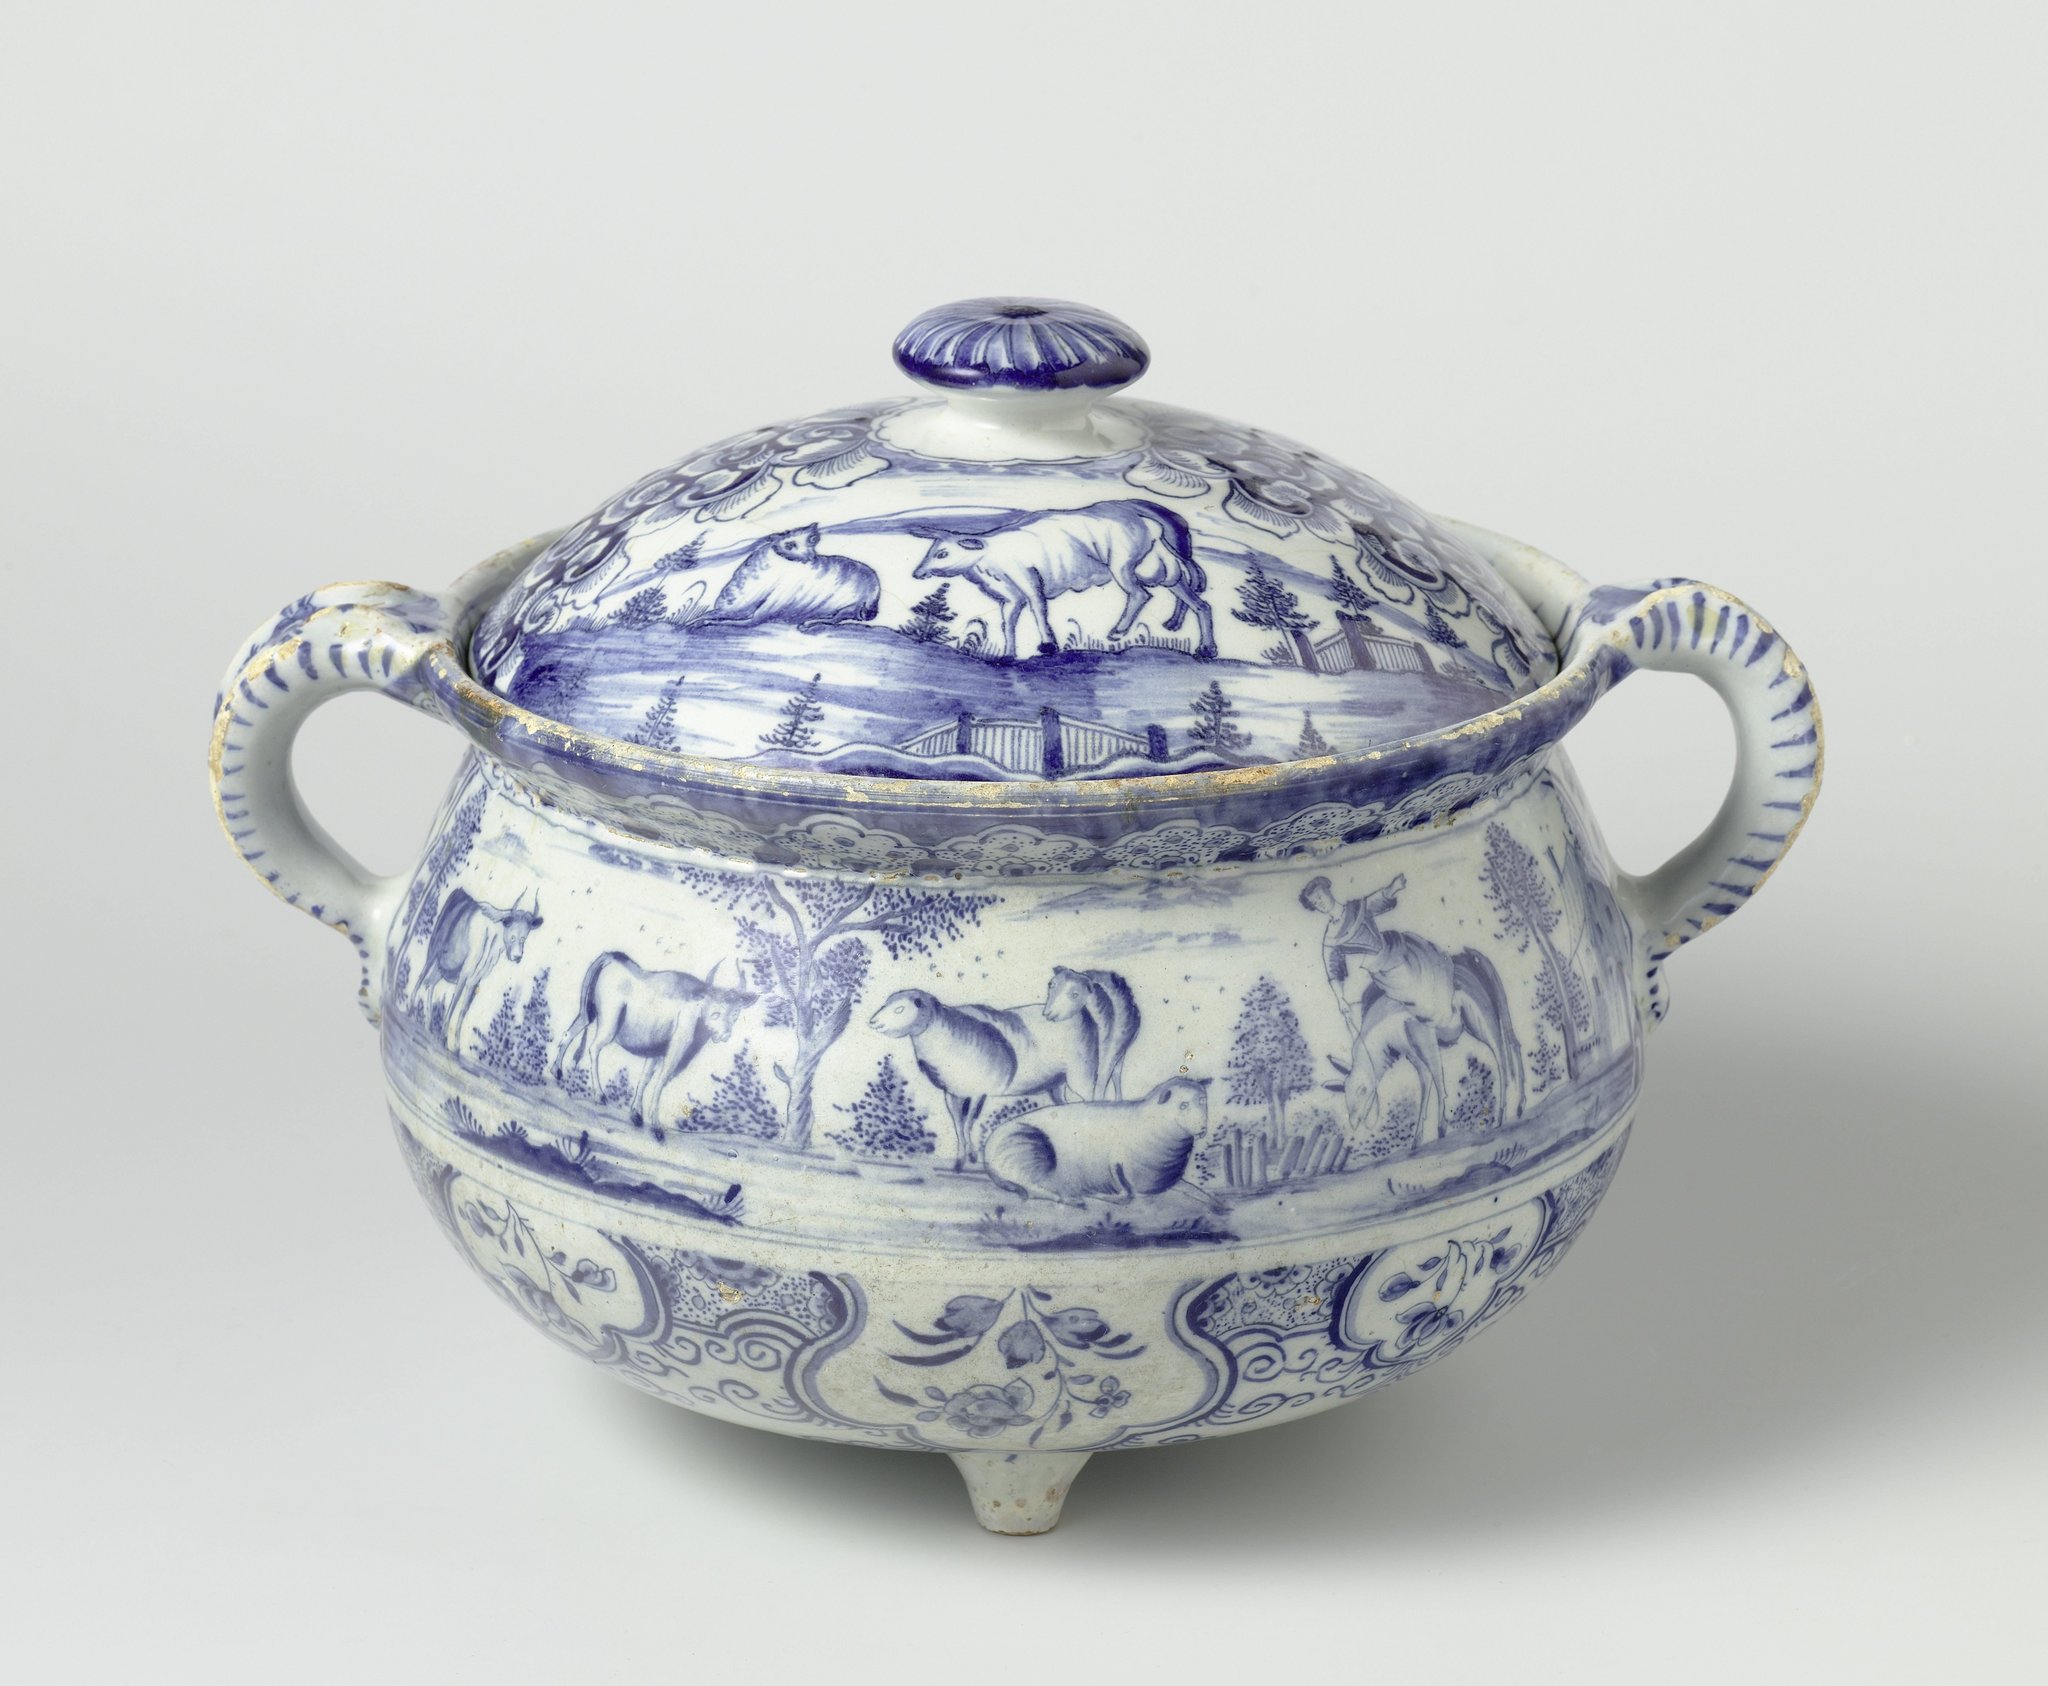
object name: pot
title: Roompot, beschilderd met landelijke scenes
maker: Anonymous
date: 1767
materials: faience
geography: delft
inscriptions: inscription: ‘IAN:IANSE:TETTE:ROO 9M1767:23D’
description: Roompot met deksel van faience met opschrift Jan Janse Tetteroo 9M1767: 23D.